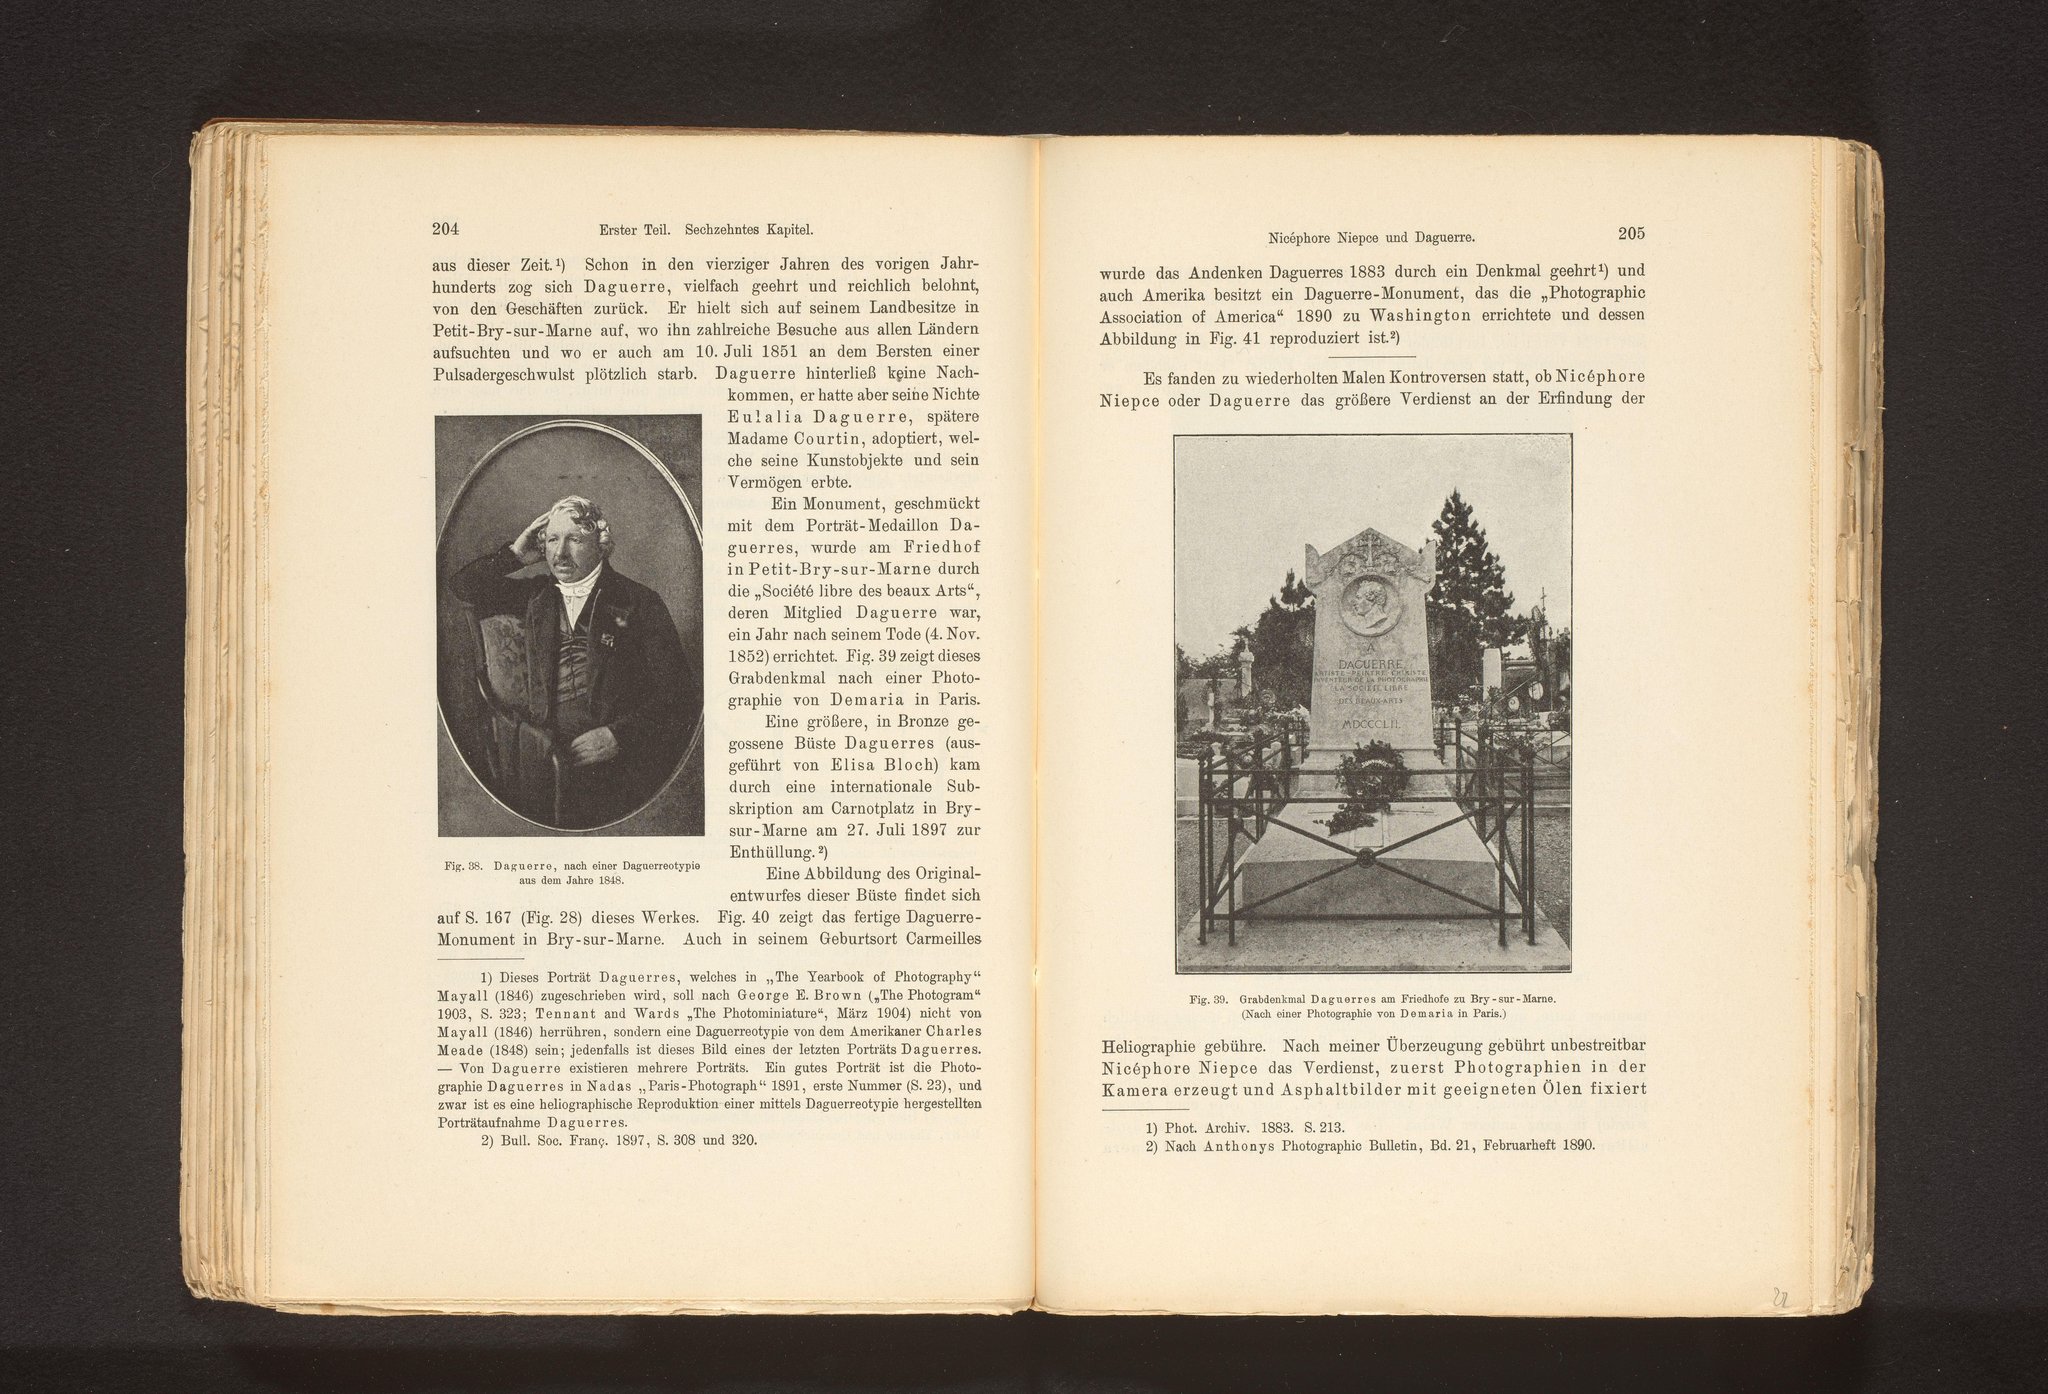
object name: photomechanical print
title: Graf van Louis Daguerre op de begraafplaats te Bry-sur-Marne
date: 1900-1905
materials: paper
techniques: autotype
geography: bry-sur-marne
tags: grave, tomb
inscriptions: number: ‘Fig. 39.’